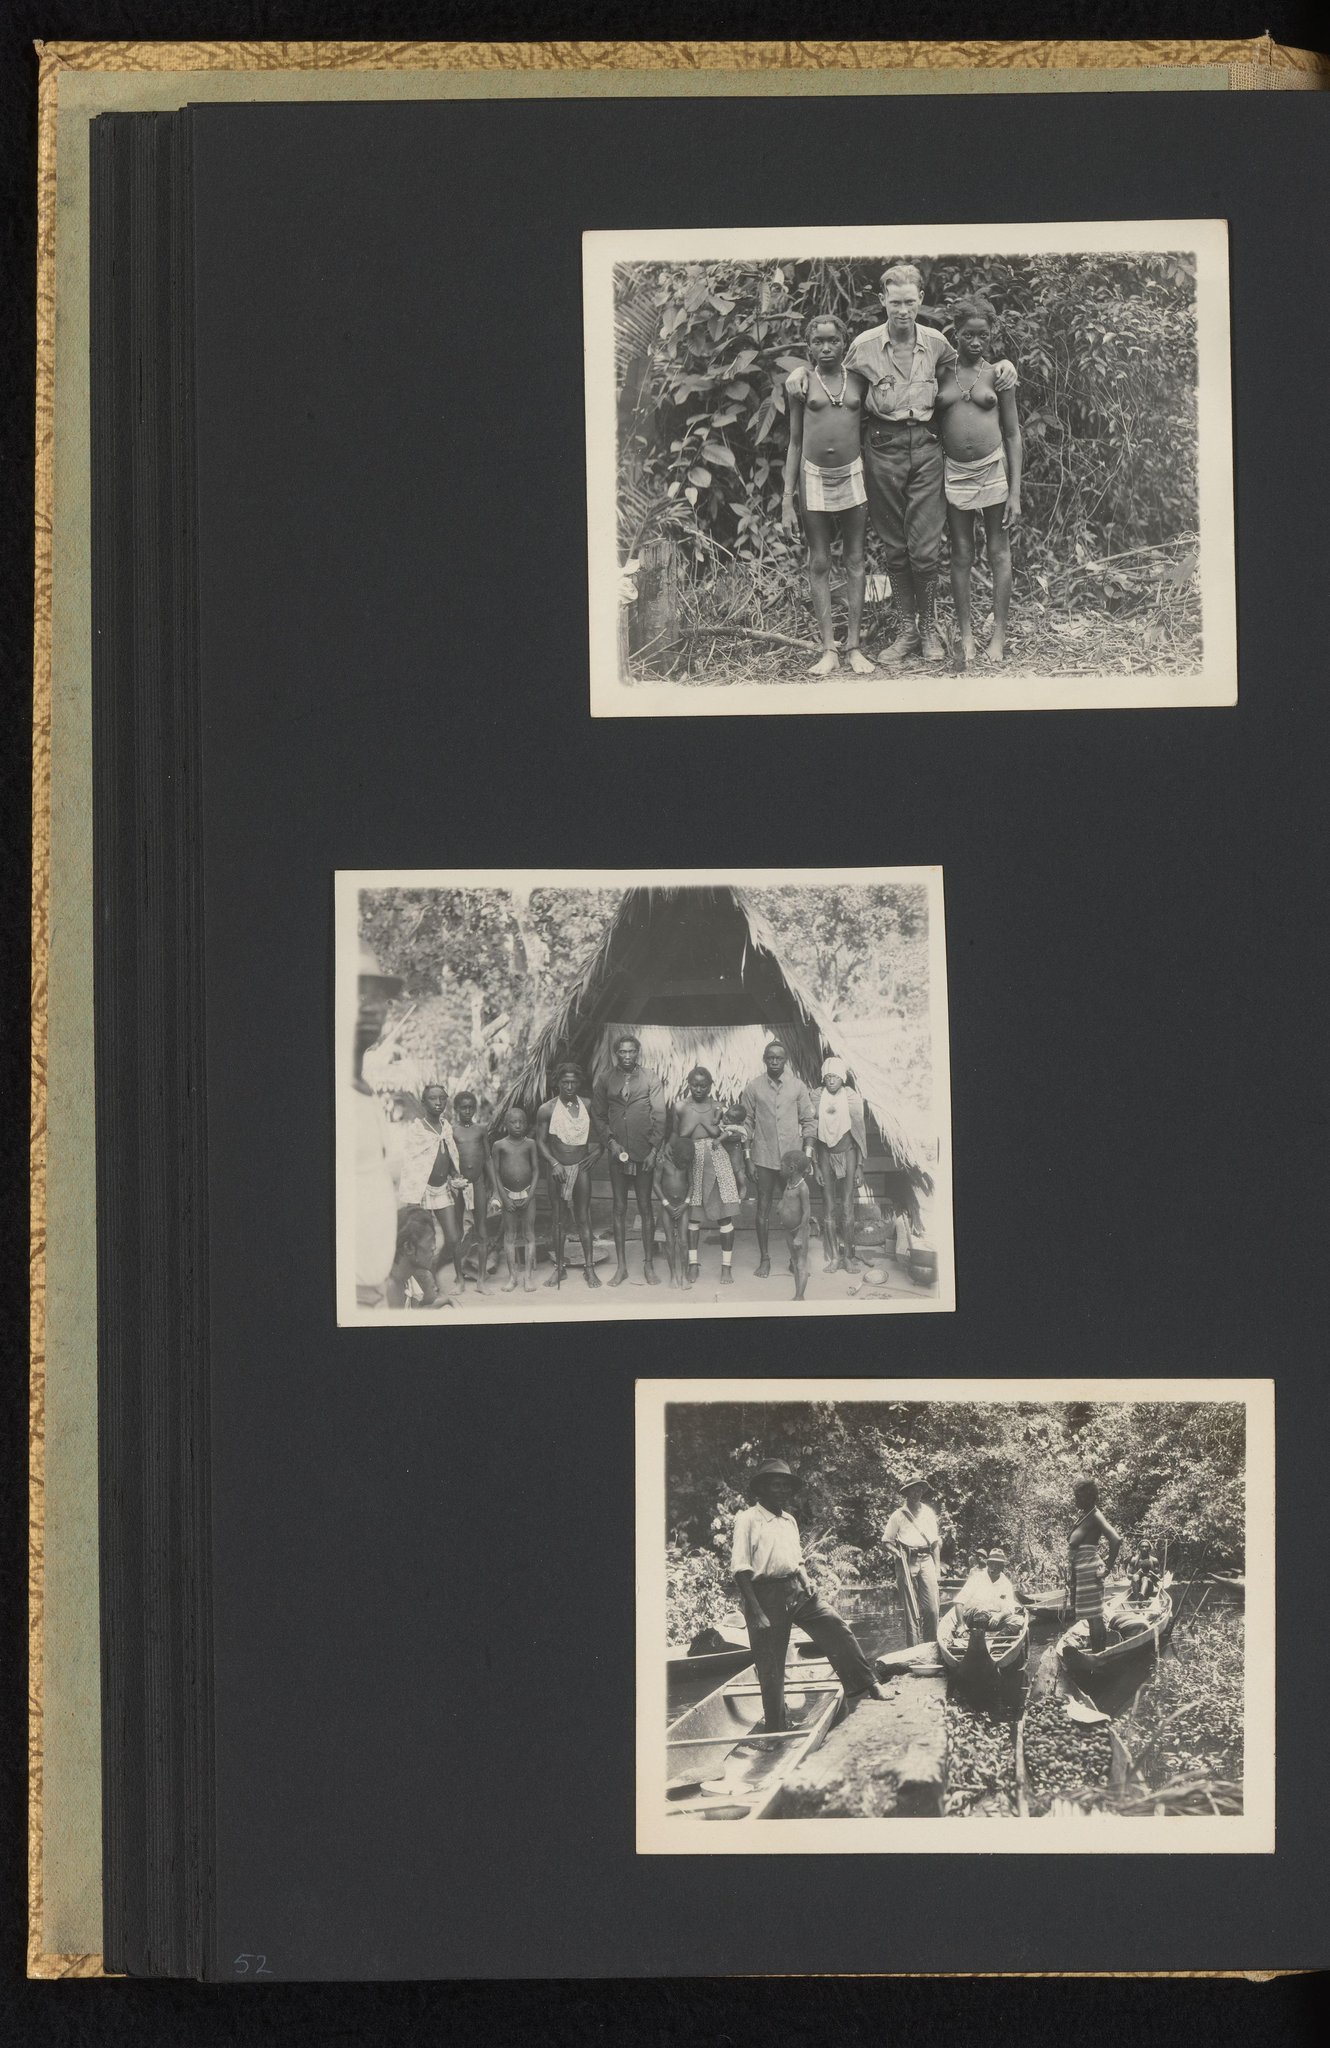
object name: photograph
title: Bezoek aan een dorp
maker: Anonymous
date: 1927-1931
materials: paper, photographic support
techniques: gelatin silver print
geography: suriname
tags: village, suriname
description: Albumblad met drie foto's van een bezoek gebracht door een groep Europeanen aan een Surinaams dorp. Onderdeel van het album van de familie Guilonard over de bauxietwinning in Moengo en Albina in Suriname in de jaren 1929-1930.